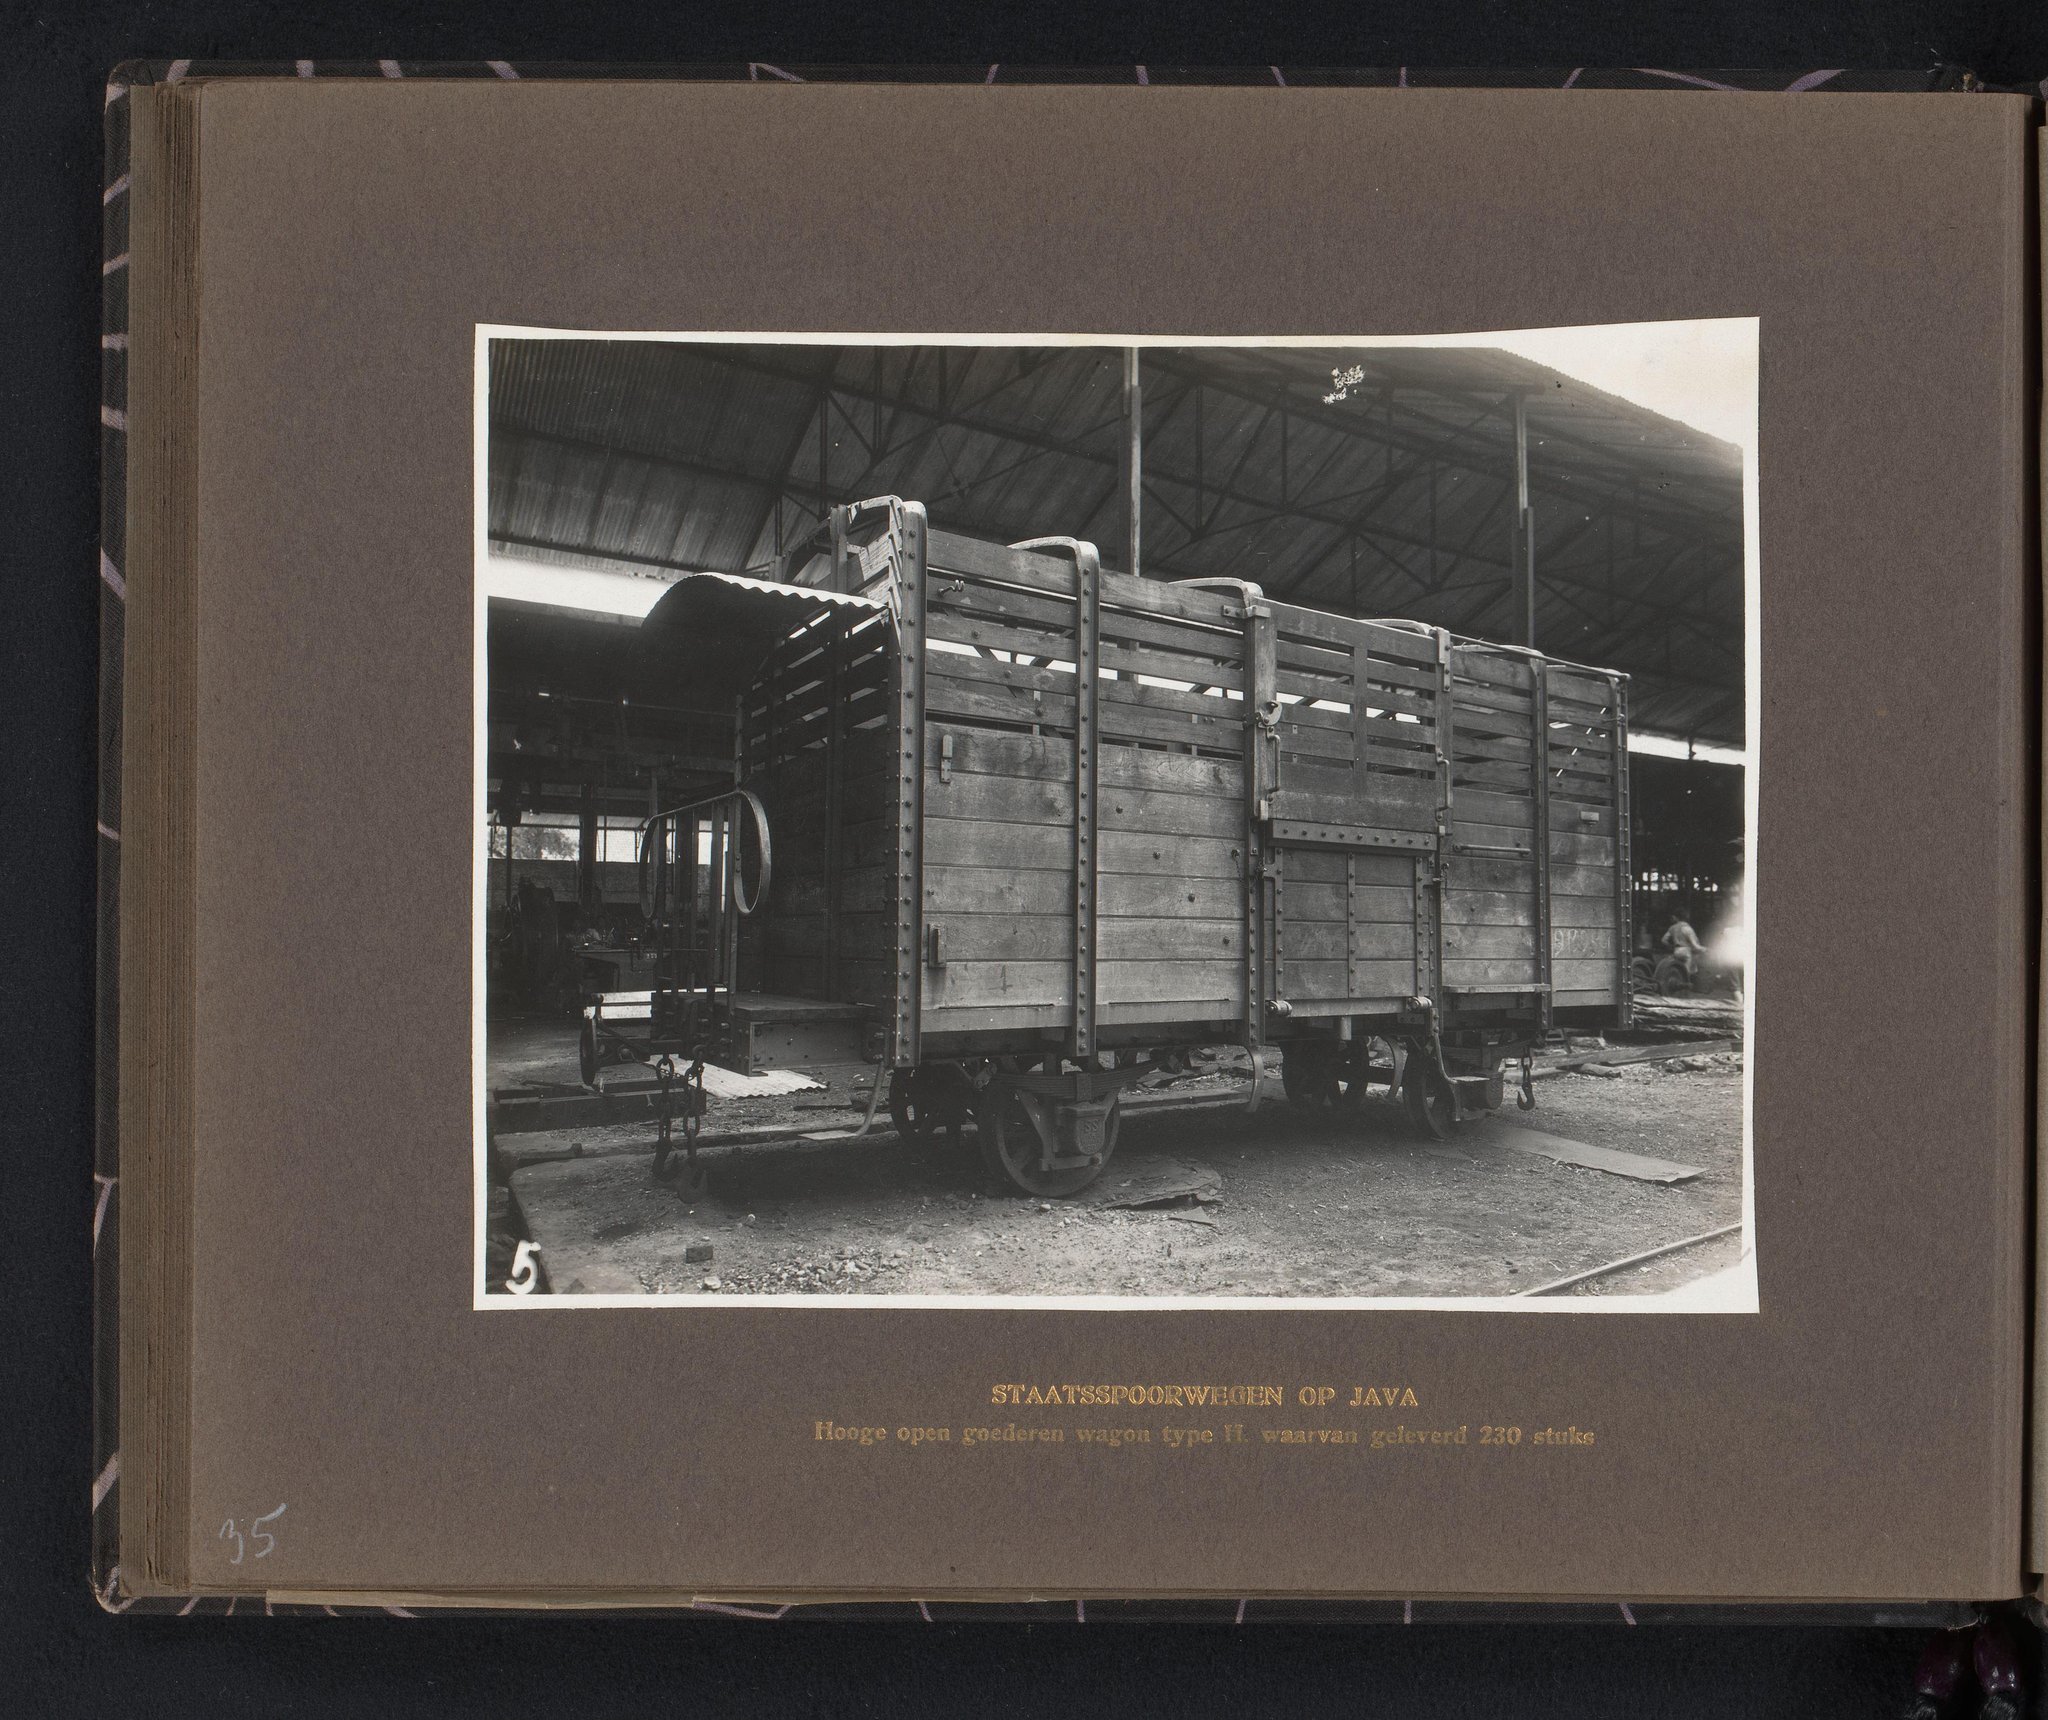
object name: photograph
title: Staatsspoorwegen op Java / Hooge open goederen wagon type H. waarvan geleverd 230 stuks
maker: Anonymous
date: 1916-1924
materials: cardboard, photographic support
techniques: gelatin silver print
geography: surabaya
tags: colonial system, factory-interior, machine shop, freight train, railway wagon, java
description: Albumblad met een foto van een type spoorwagon. Vervaardigd door Machinefabriek Braat en geleverd aan de Staatsspoorwegen op Java. Onderdeel van het fotoalbum Machinefabriek Braat Soerabaia-Djocja-Tegal, ca. 1916-1924.